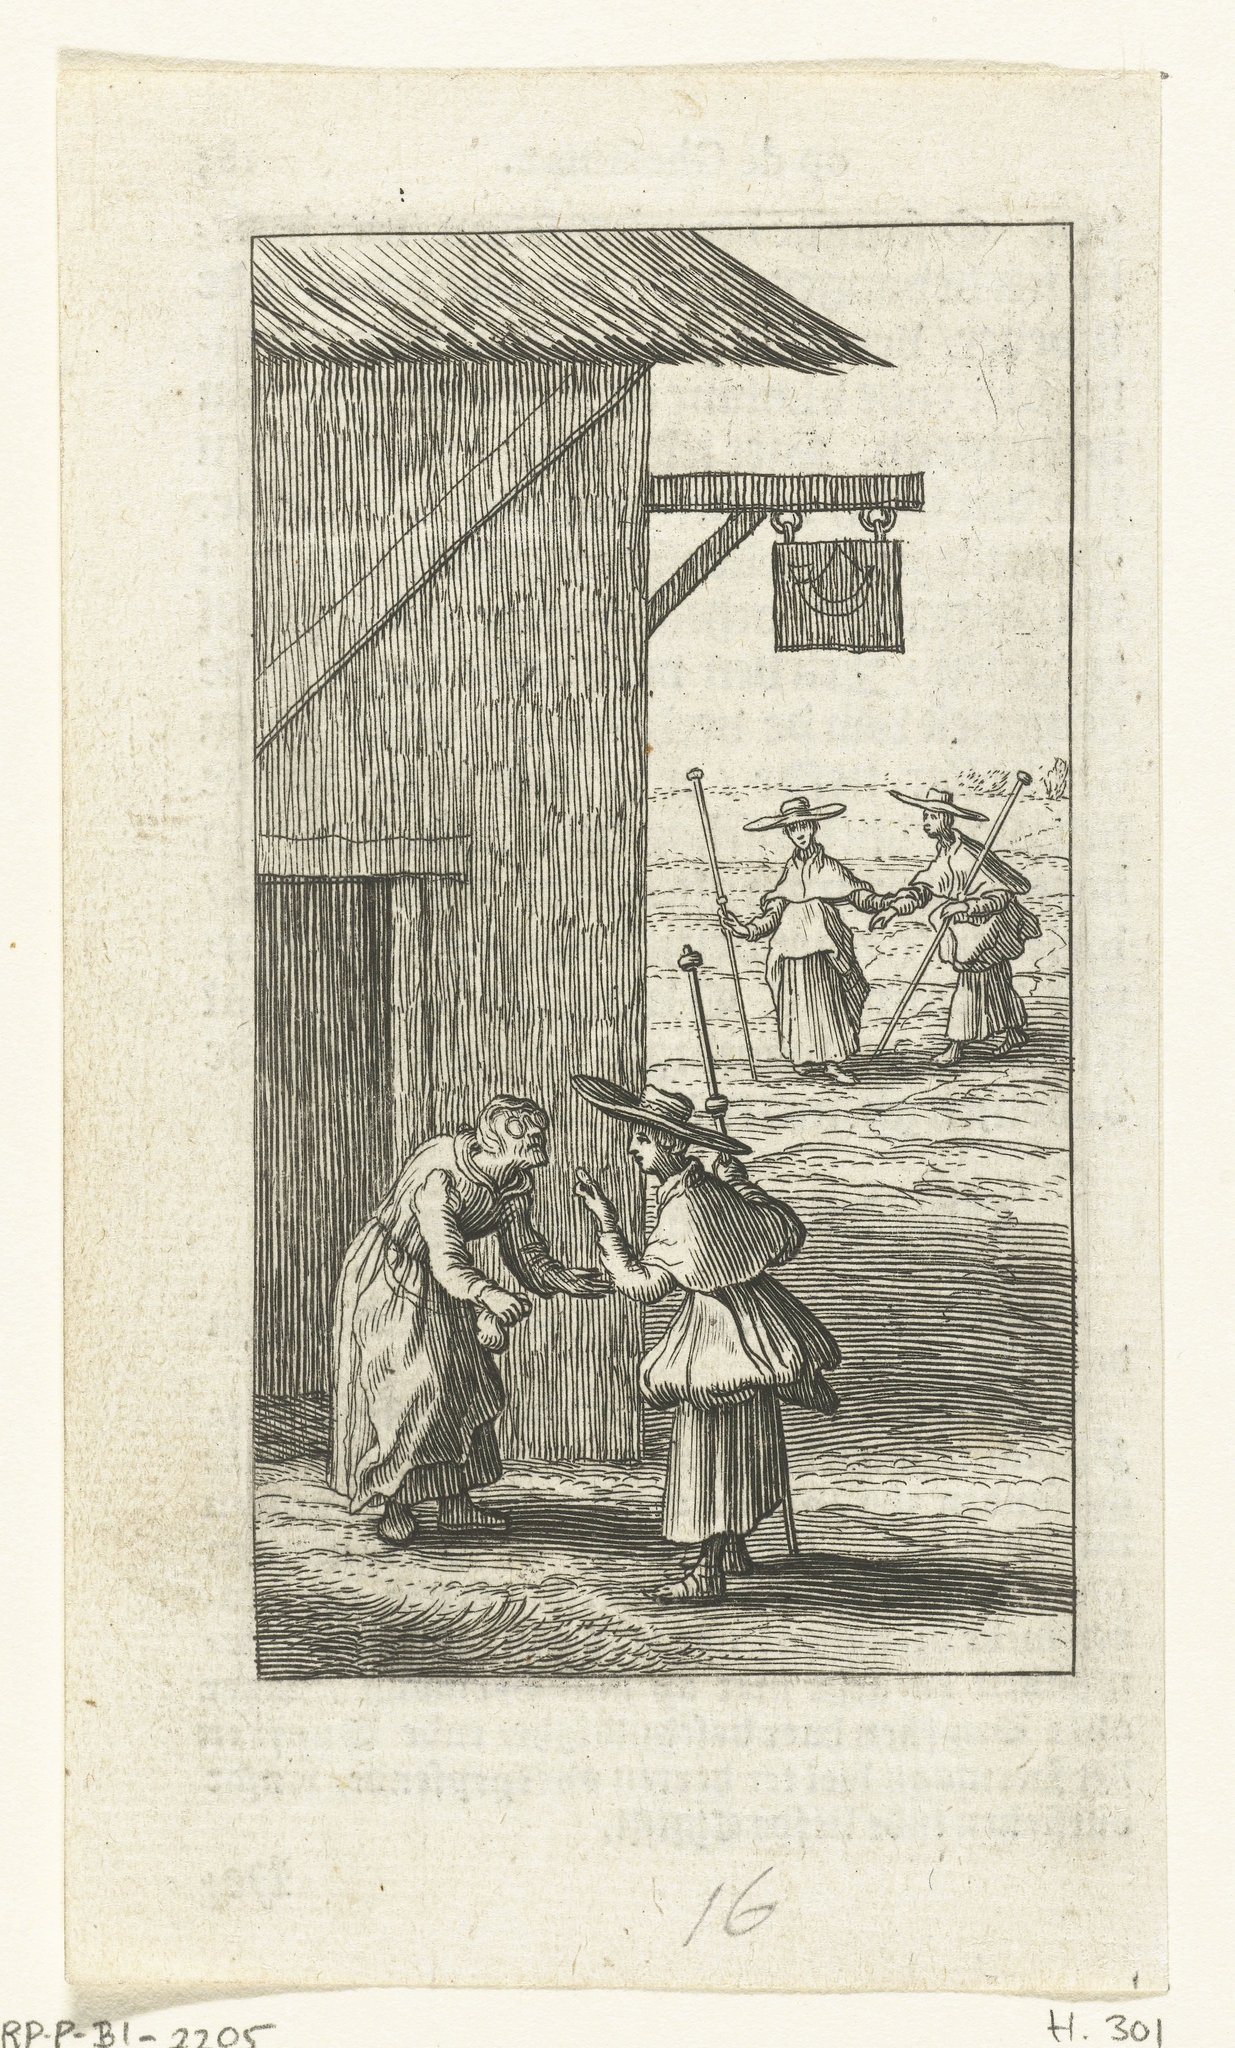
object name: print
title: Duyfkens en Willemynkens pelgrimagie tot haren beminden binnen Iervsalem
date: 1590-1627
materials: paper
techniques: engraving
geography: antwerp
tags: old woman, pilgrimage, pilgrim(s) under way, beggar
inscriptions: collector's mark: Lugt 2228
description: Prent uit: Boëtius Adamsz. Bolswert, Duyfkens en Willemynkens pelgrimagie tot haren beminden binnen Iervsalem. Haerlieder teghenspoet, belet en eynde, Antwerpen, Hendrick Aertssens, 1638. Op het verso staat een verklarende Nederlandse tekst bij de voorgaande illustratie in dit devotie boekje (vergelijk RP-P-BI-2204).